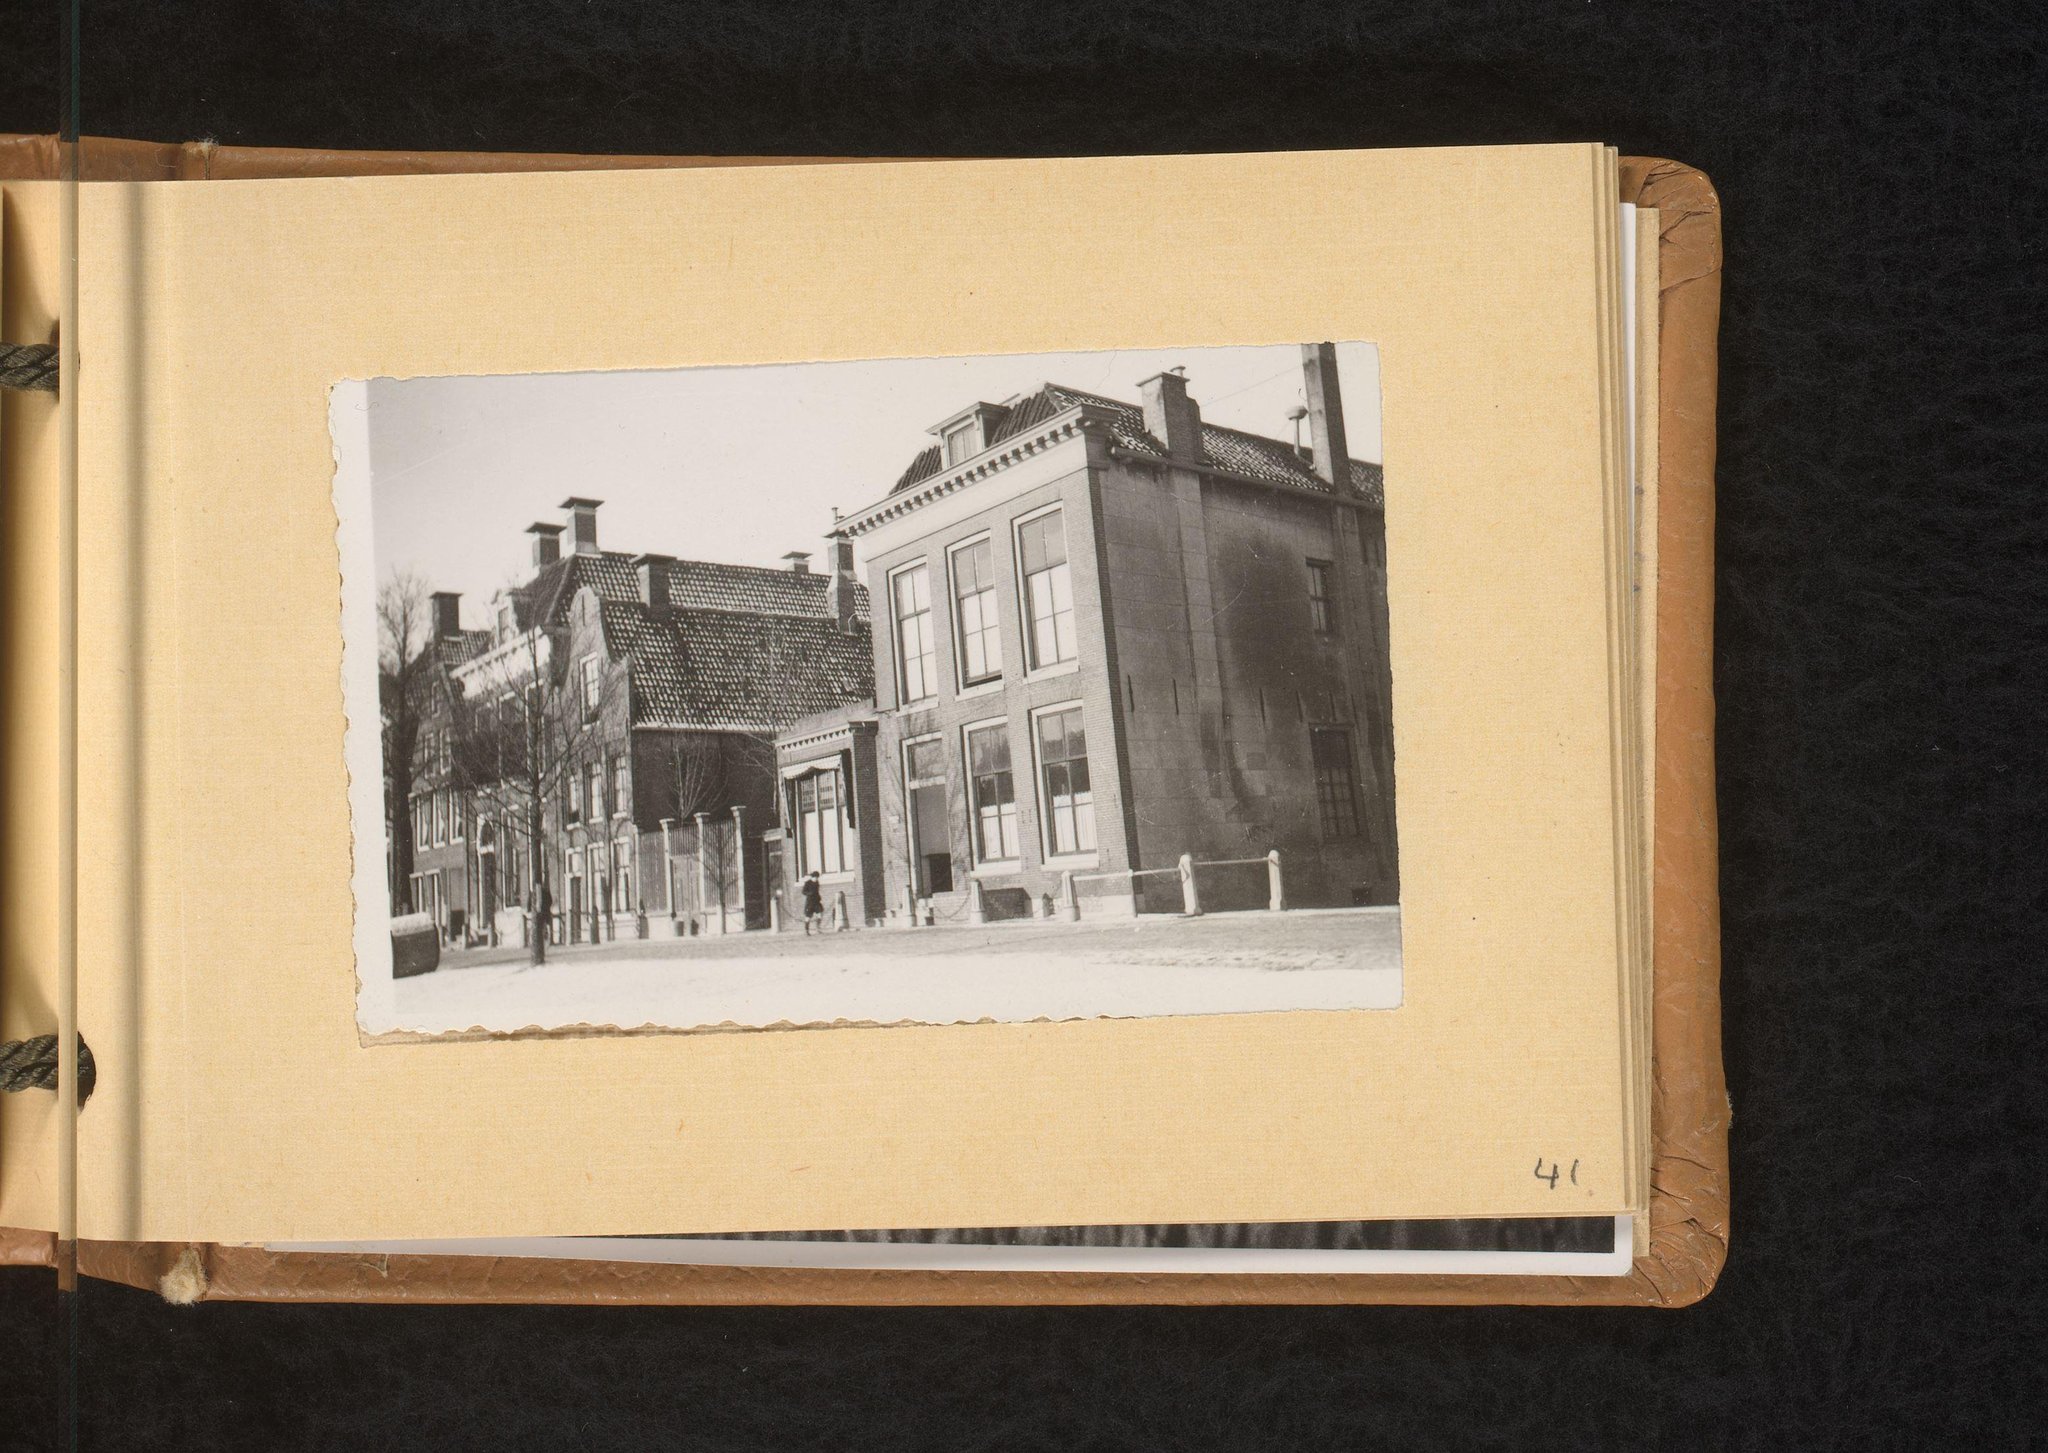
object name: photograph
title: Gebouw van de Kriegsmarine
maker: Anonymous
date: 1940-1943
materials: paper, photographic support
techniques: gelatin silver print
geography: netherlands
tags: shelter ~ military service, occupation ~ war, public road (+ city(-scape) with figures, staffage), netherlands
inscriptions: name: ‘Fotob Zegel 255’, inscription: ‘Unsere ...’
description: Albumblad met een foto van een rij huizen in een Nederlandse stad met rechts het gebouw van de Kriegsmarie (Dienststelle 23 443). Onderdeel van een klein album van de Kriegsmarine in Nederland.